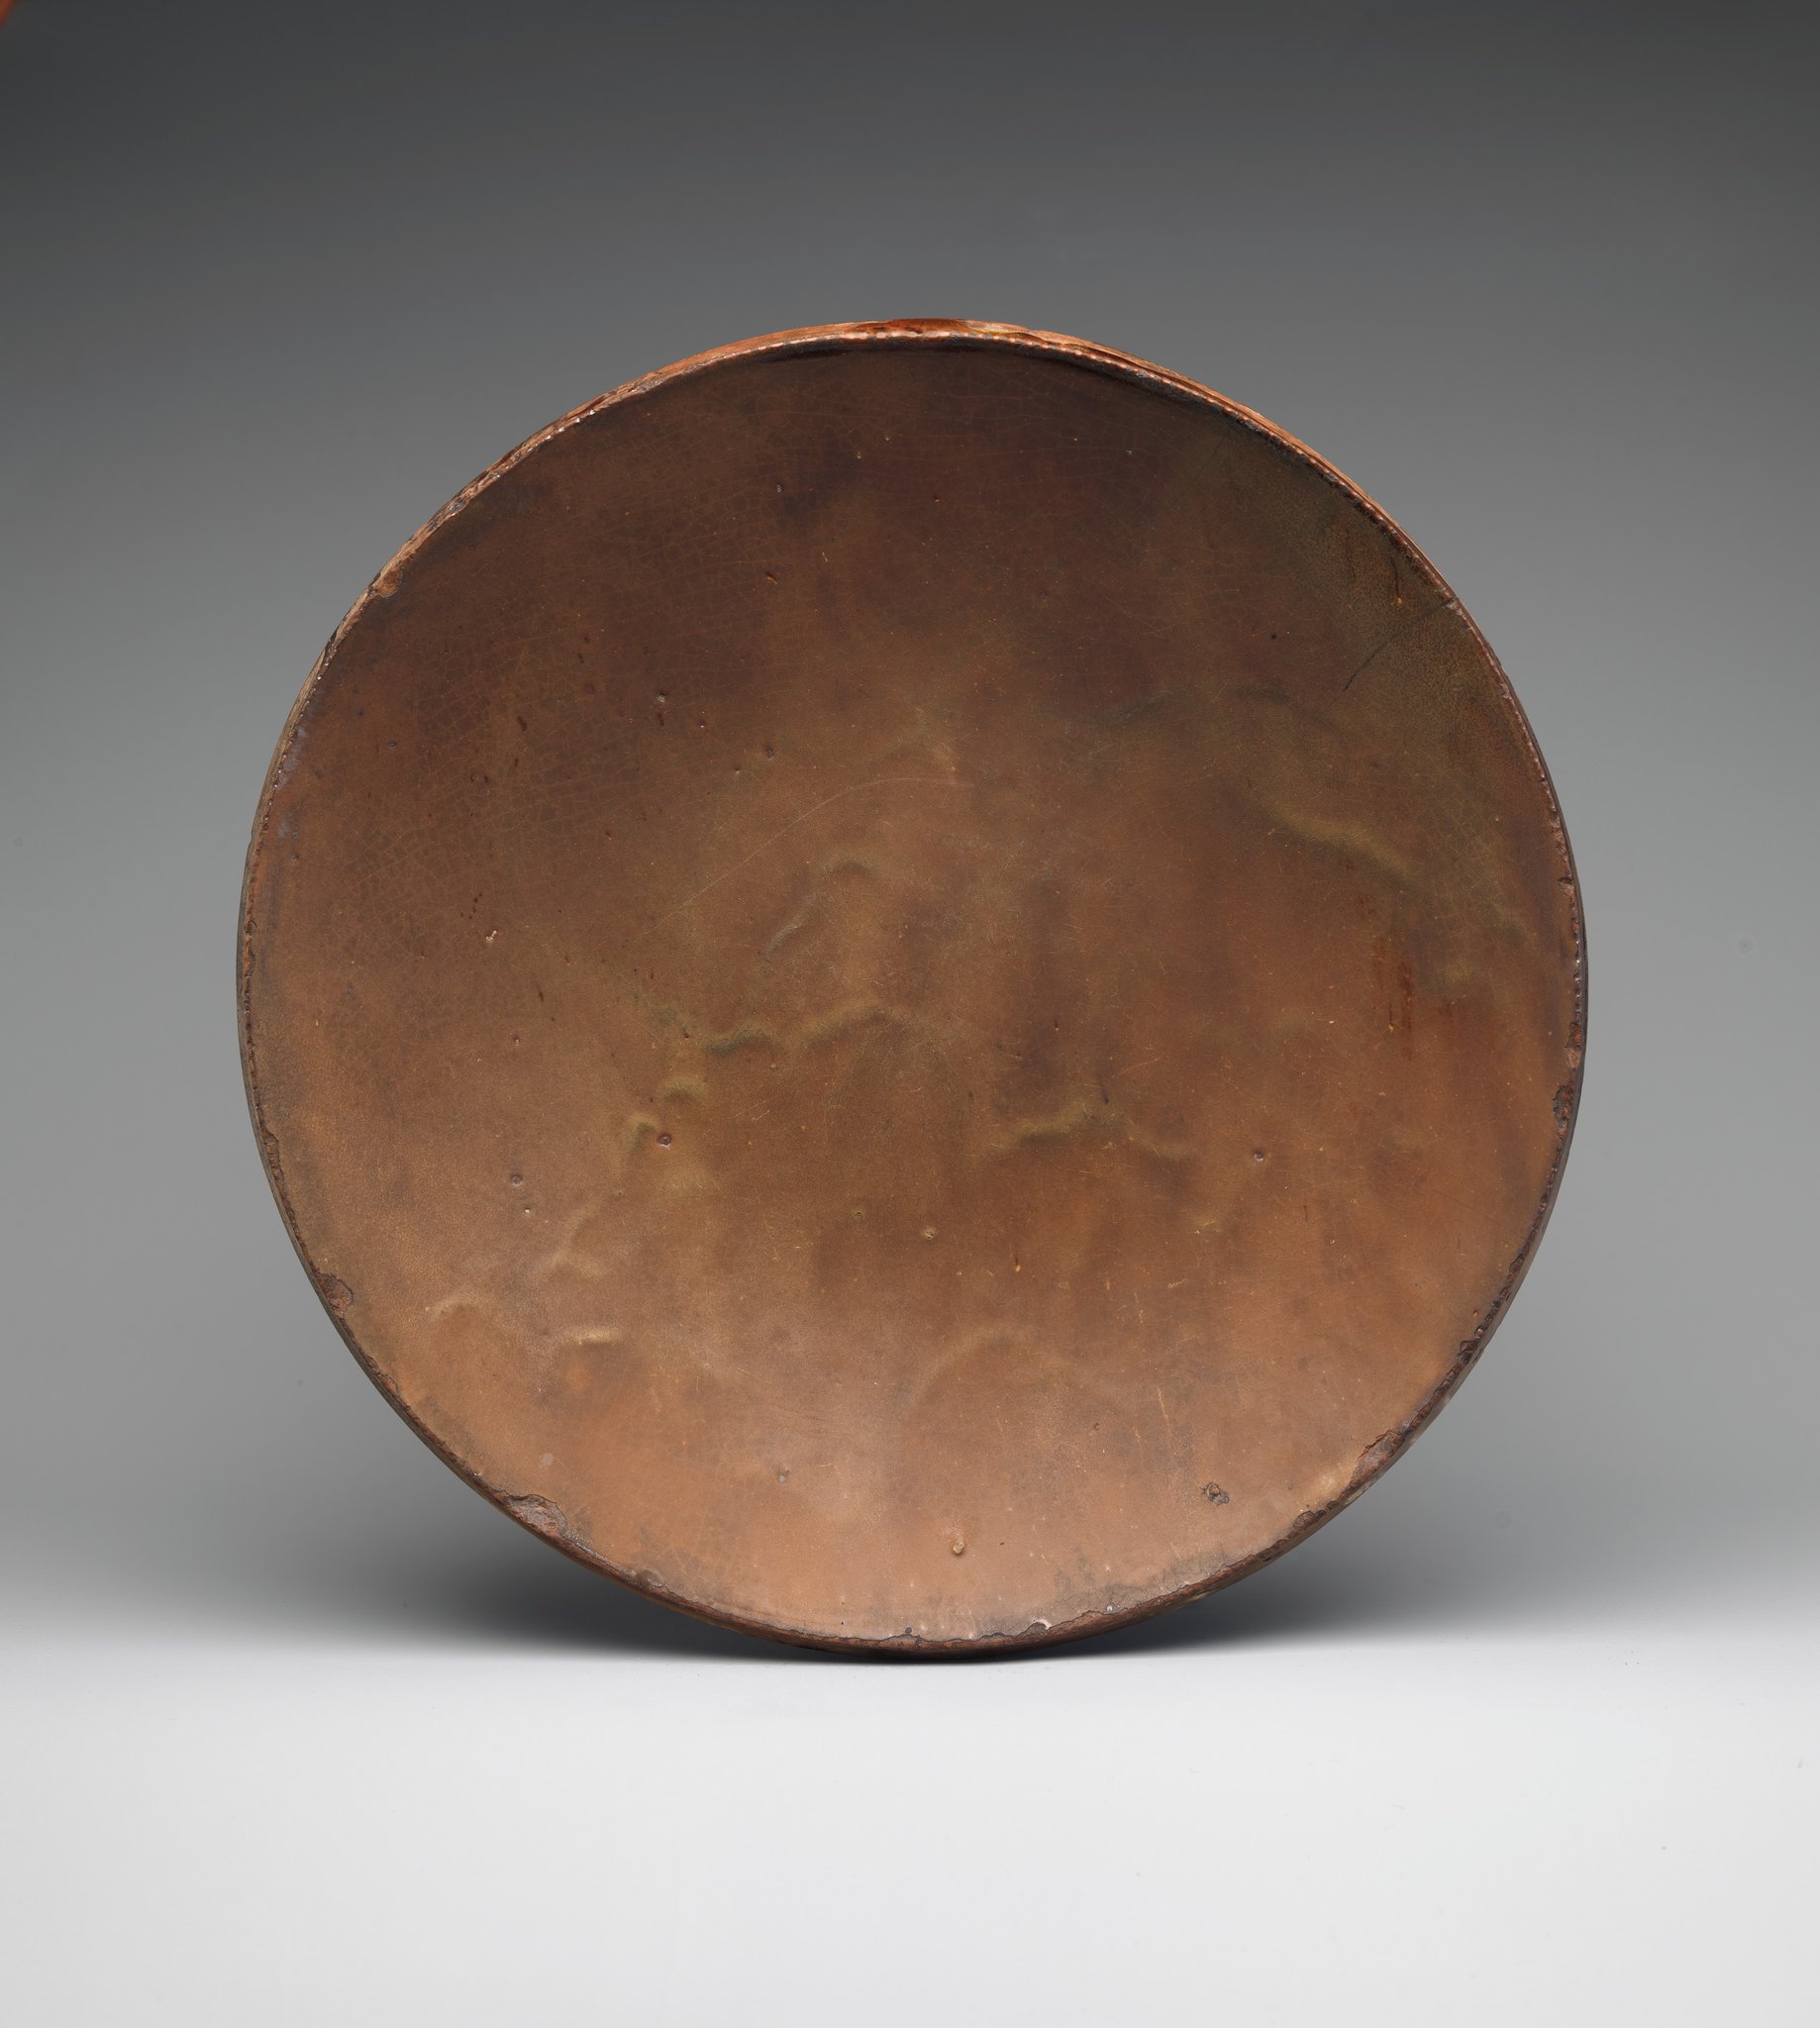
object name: pie dish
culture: american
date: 1800-1830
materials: earthenware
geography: united states